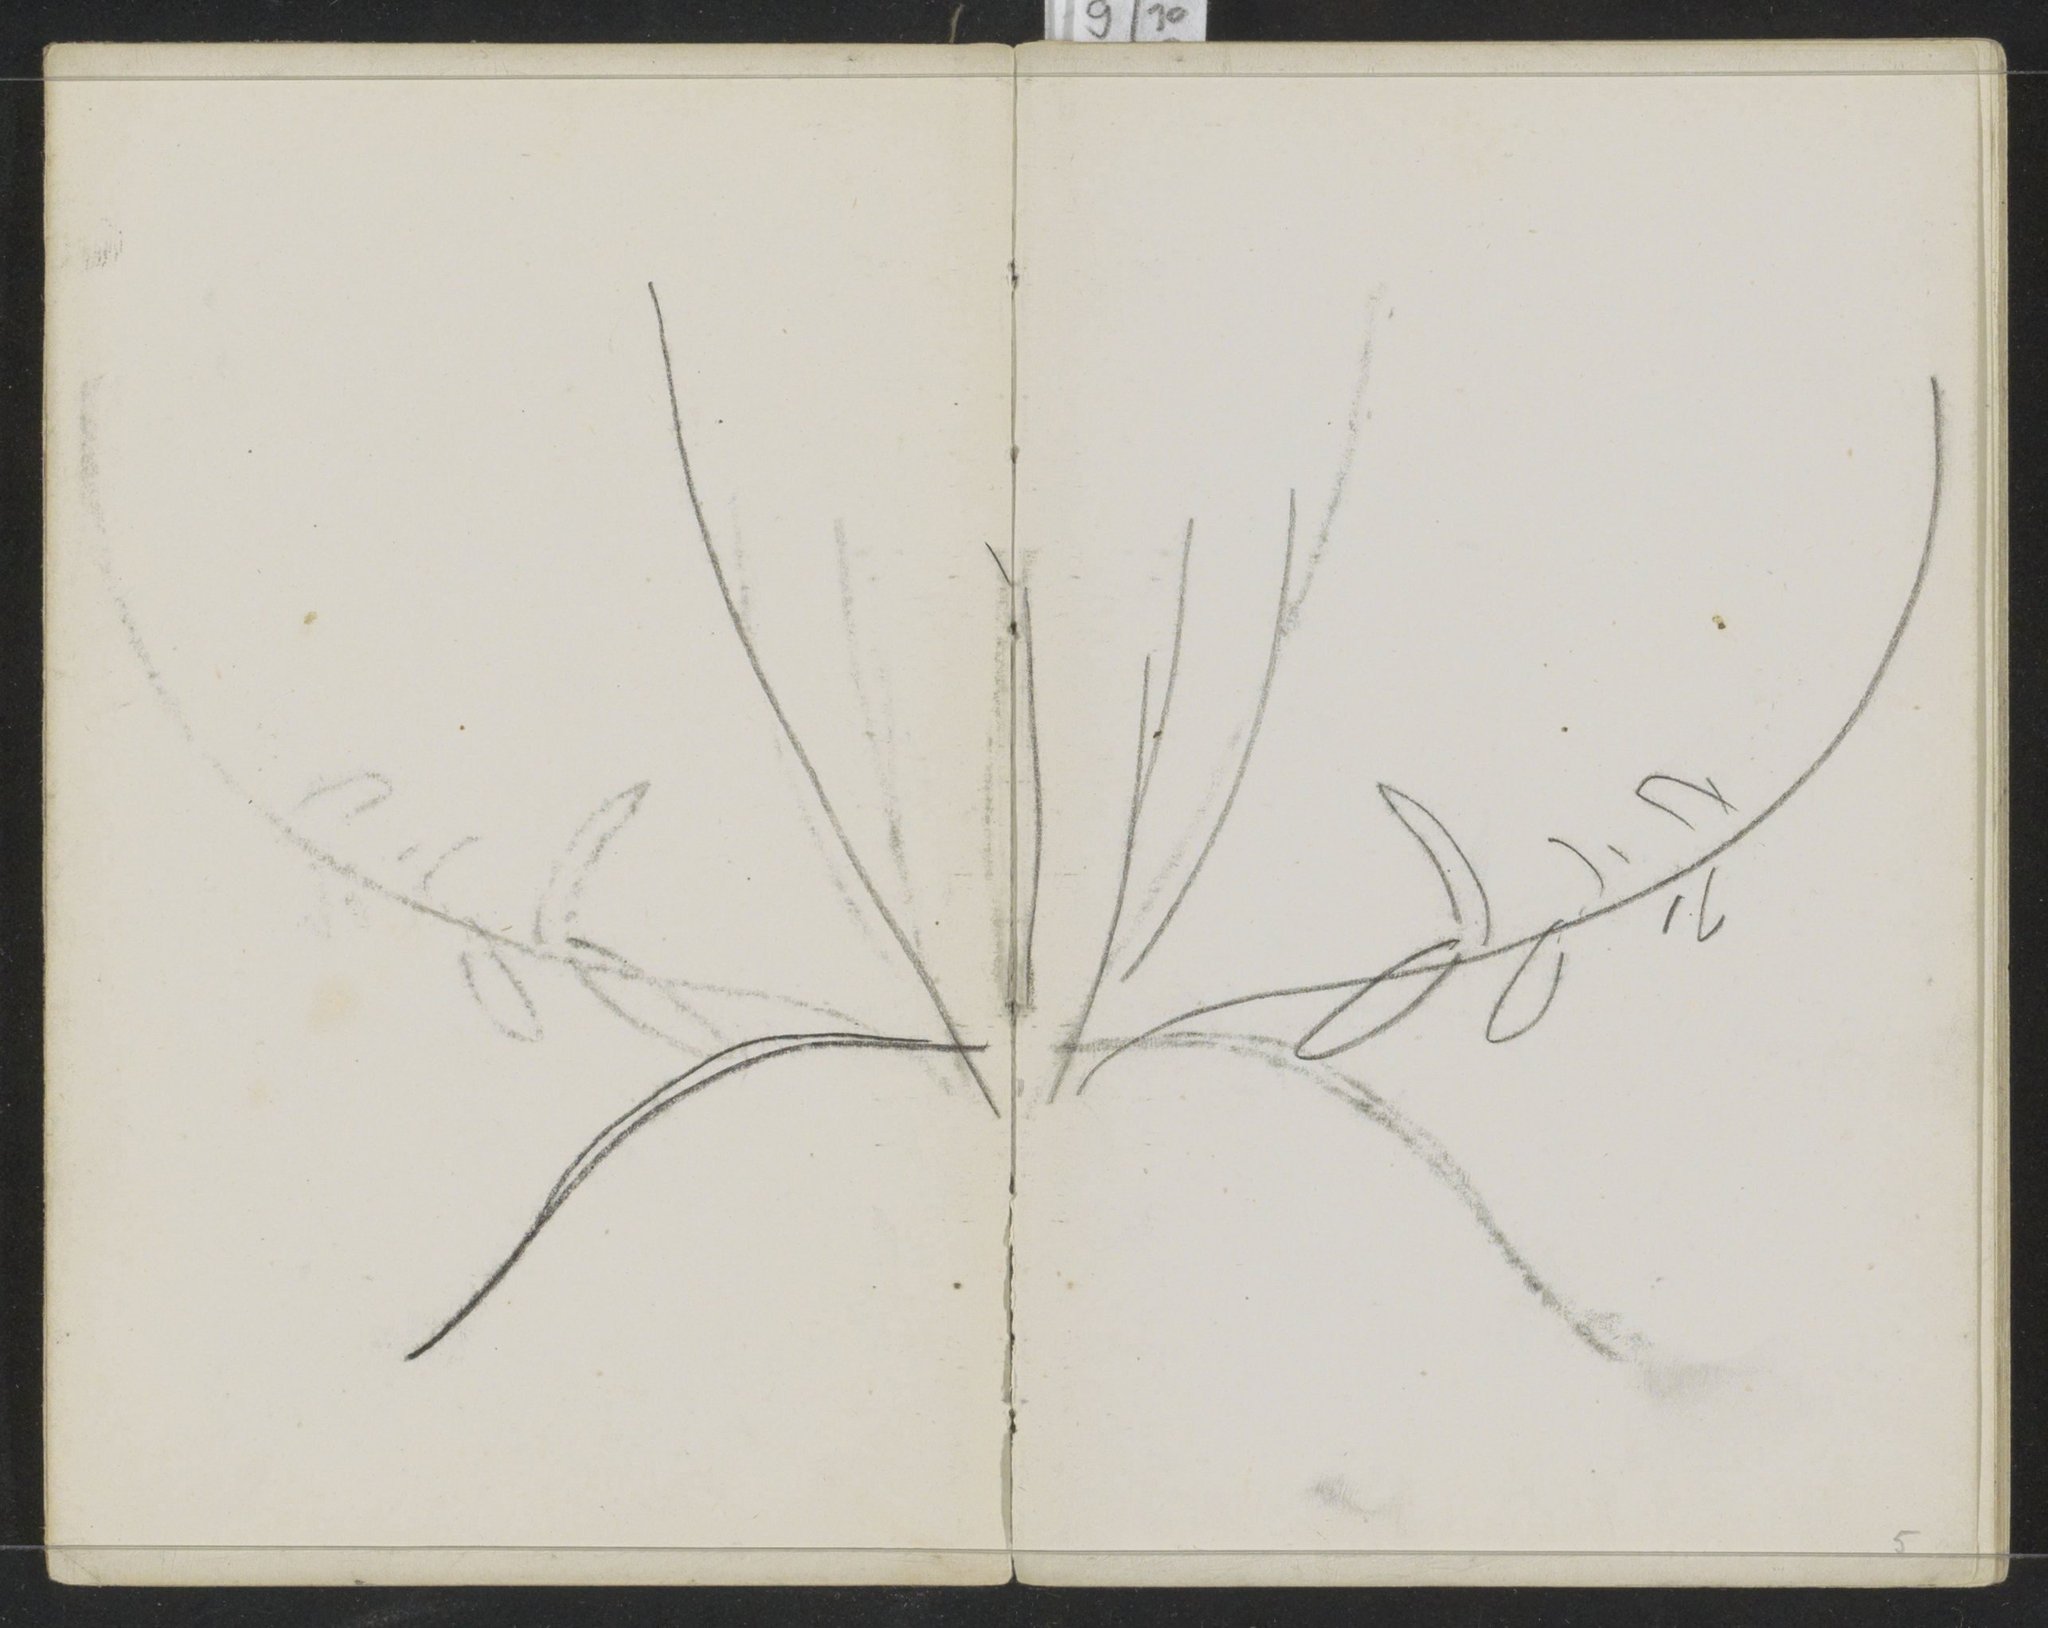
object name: sketchbook leaf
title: Plantmotief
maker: carel adolph lion cachet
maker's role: draughtsman, print maker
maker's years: 1864-1945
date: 1874-1945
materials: chalk, paper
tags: ornament derived from plant forms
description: Blad 4 verso en 5 recto uit een schetsboek met 41 bladen.